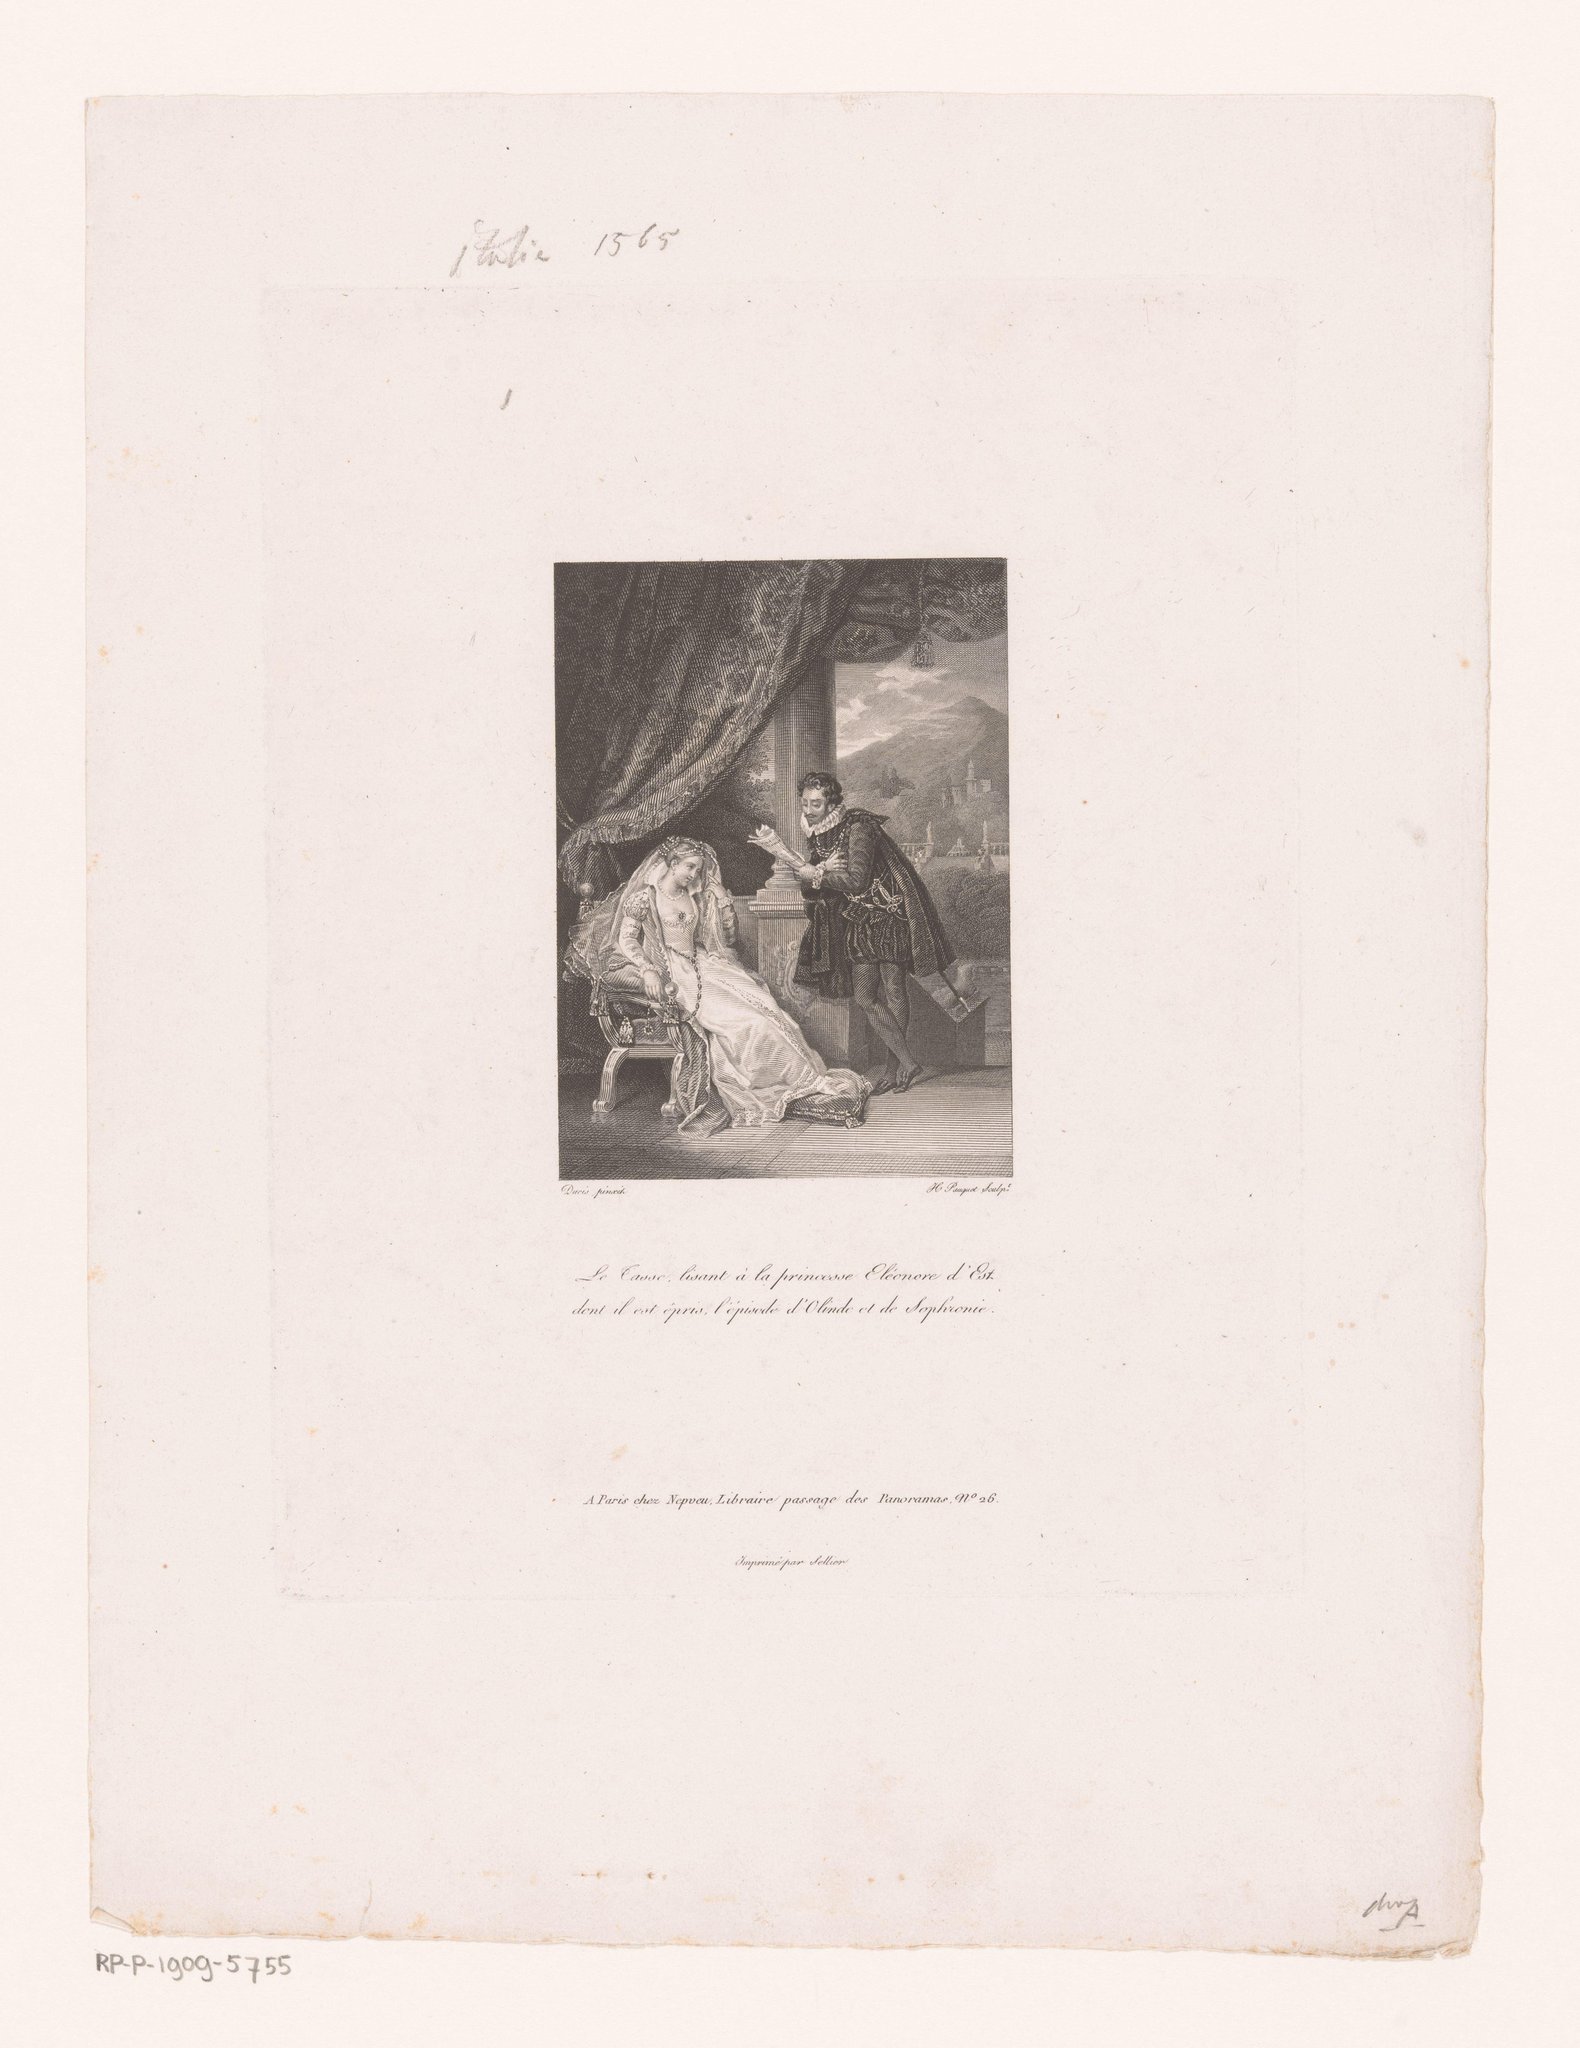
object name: print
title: Torquato Tasso en prinses Eleonora d'Este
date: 1807-1862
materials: paper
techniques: etching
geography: paris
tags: rome, torquato tasso, sofronia, olindo, (scenes from) specific works of literature: tasso, gerusalemme liberata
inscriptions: collector's mark: Lugt 2228